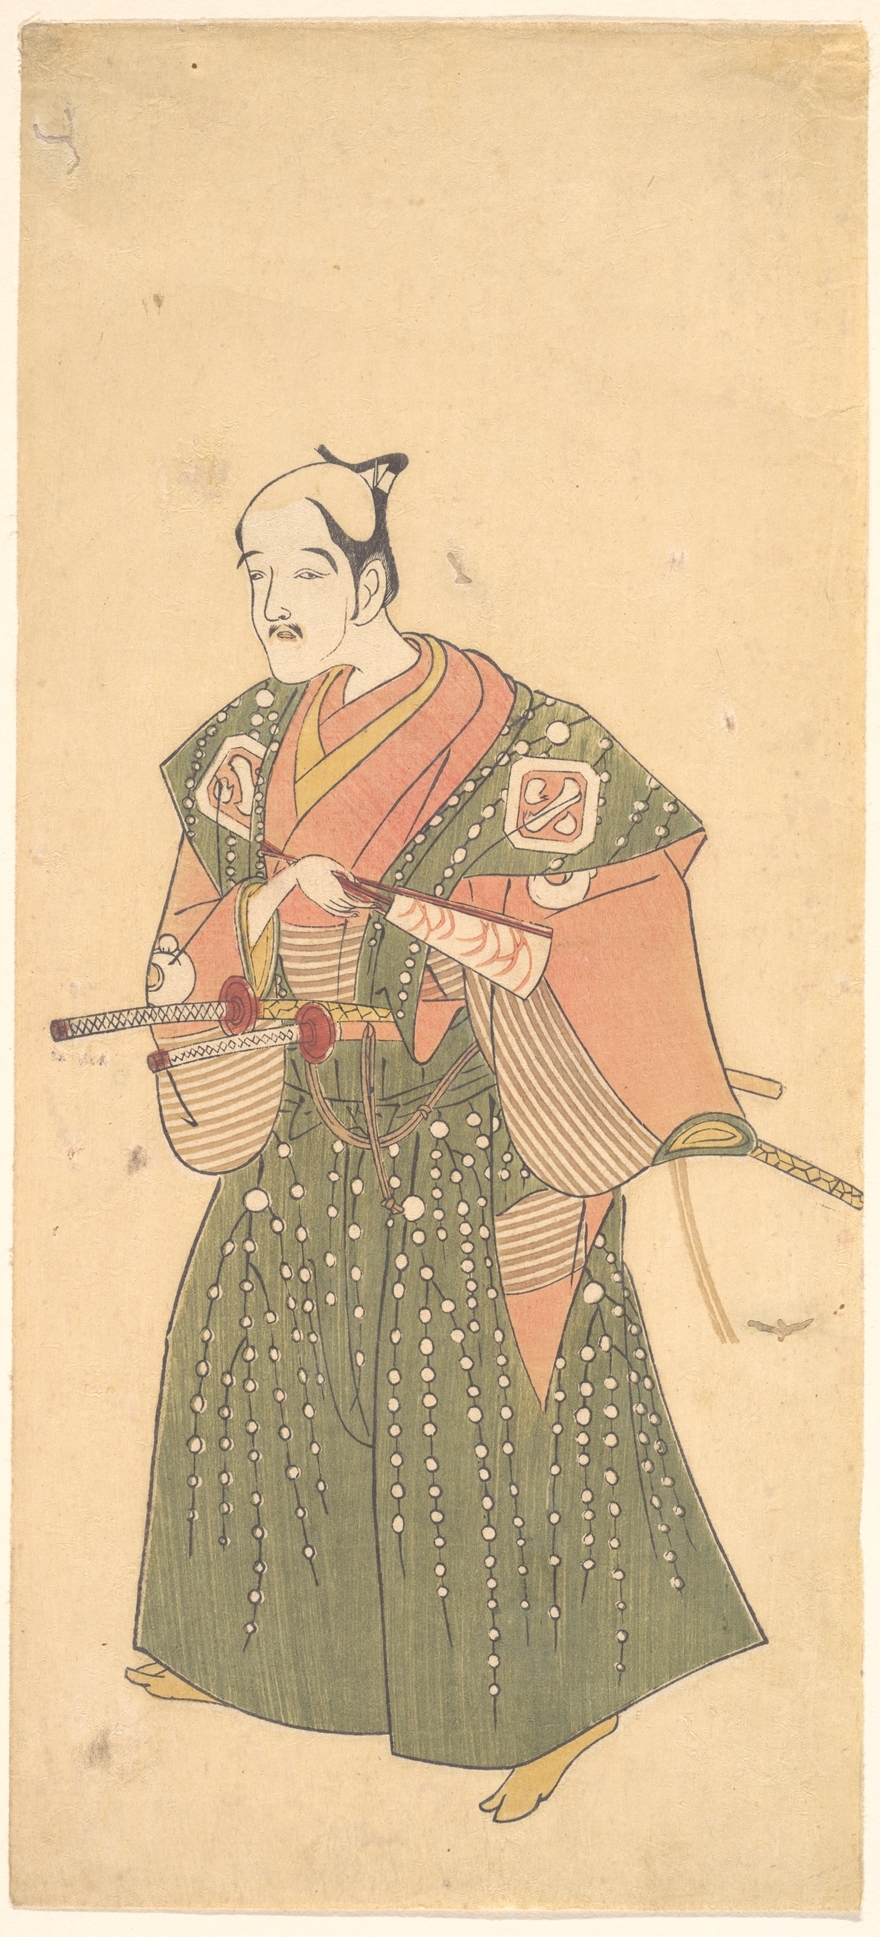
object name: woodblock print nishiki e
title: The Actor Arashi Otohachi I (facsimile?)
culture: japanese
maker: ippitsusai bunchō 一筆齊文調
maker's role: artist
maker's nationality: japanese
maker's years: 1765-1792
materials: ink, paper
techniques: nishiki e, woodblock print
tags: swords,men,actors